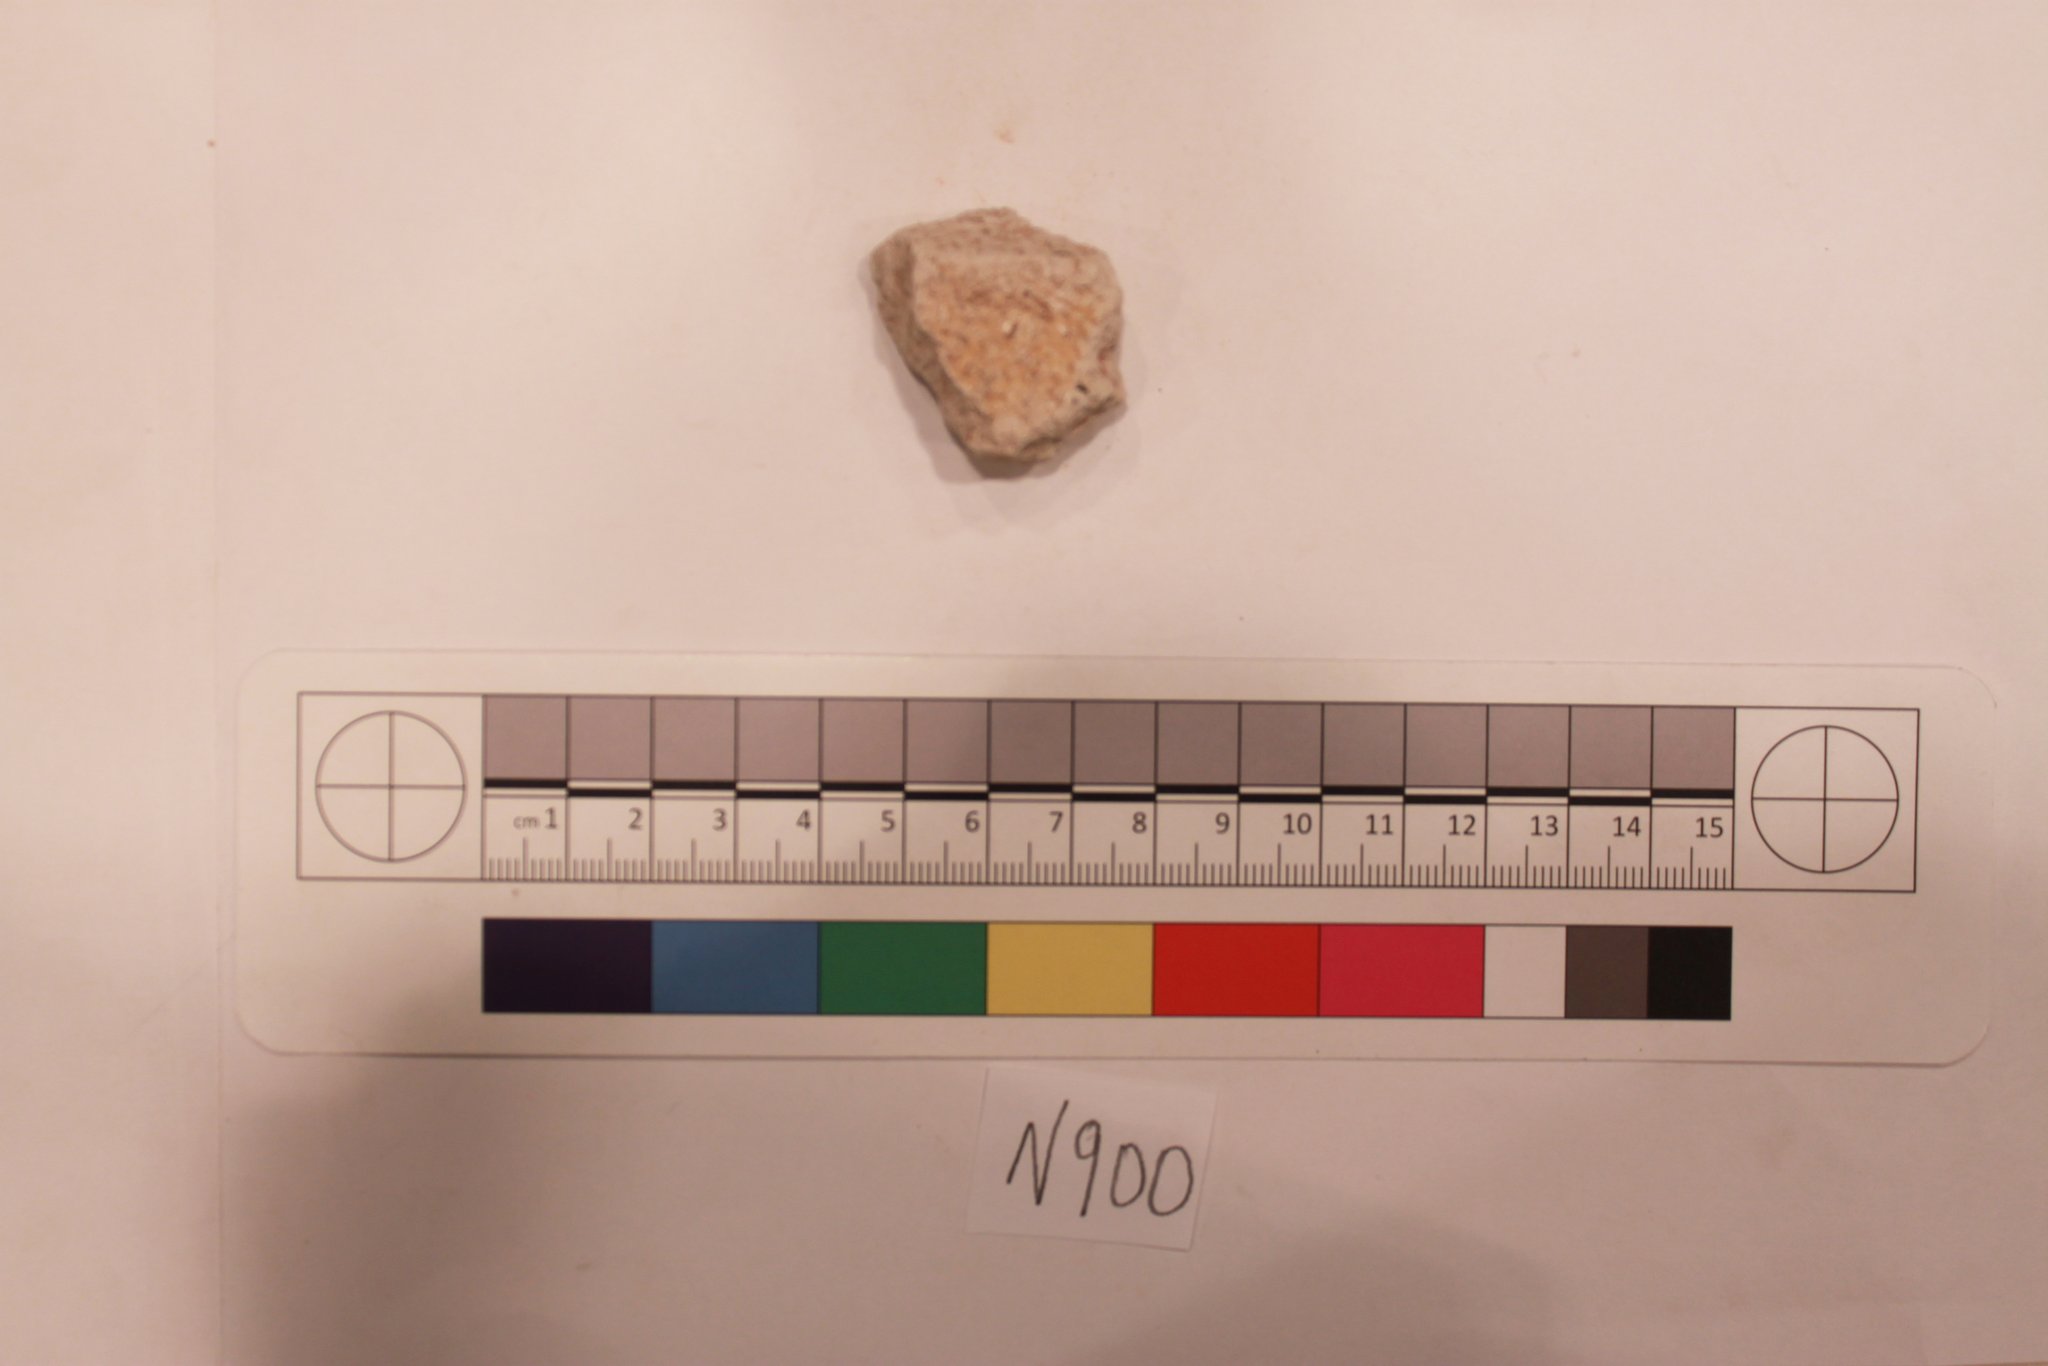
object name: fragment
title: Stucco Fragment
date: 701-1200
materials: plaster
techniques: carving, painting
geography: iran